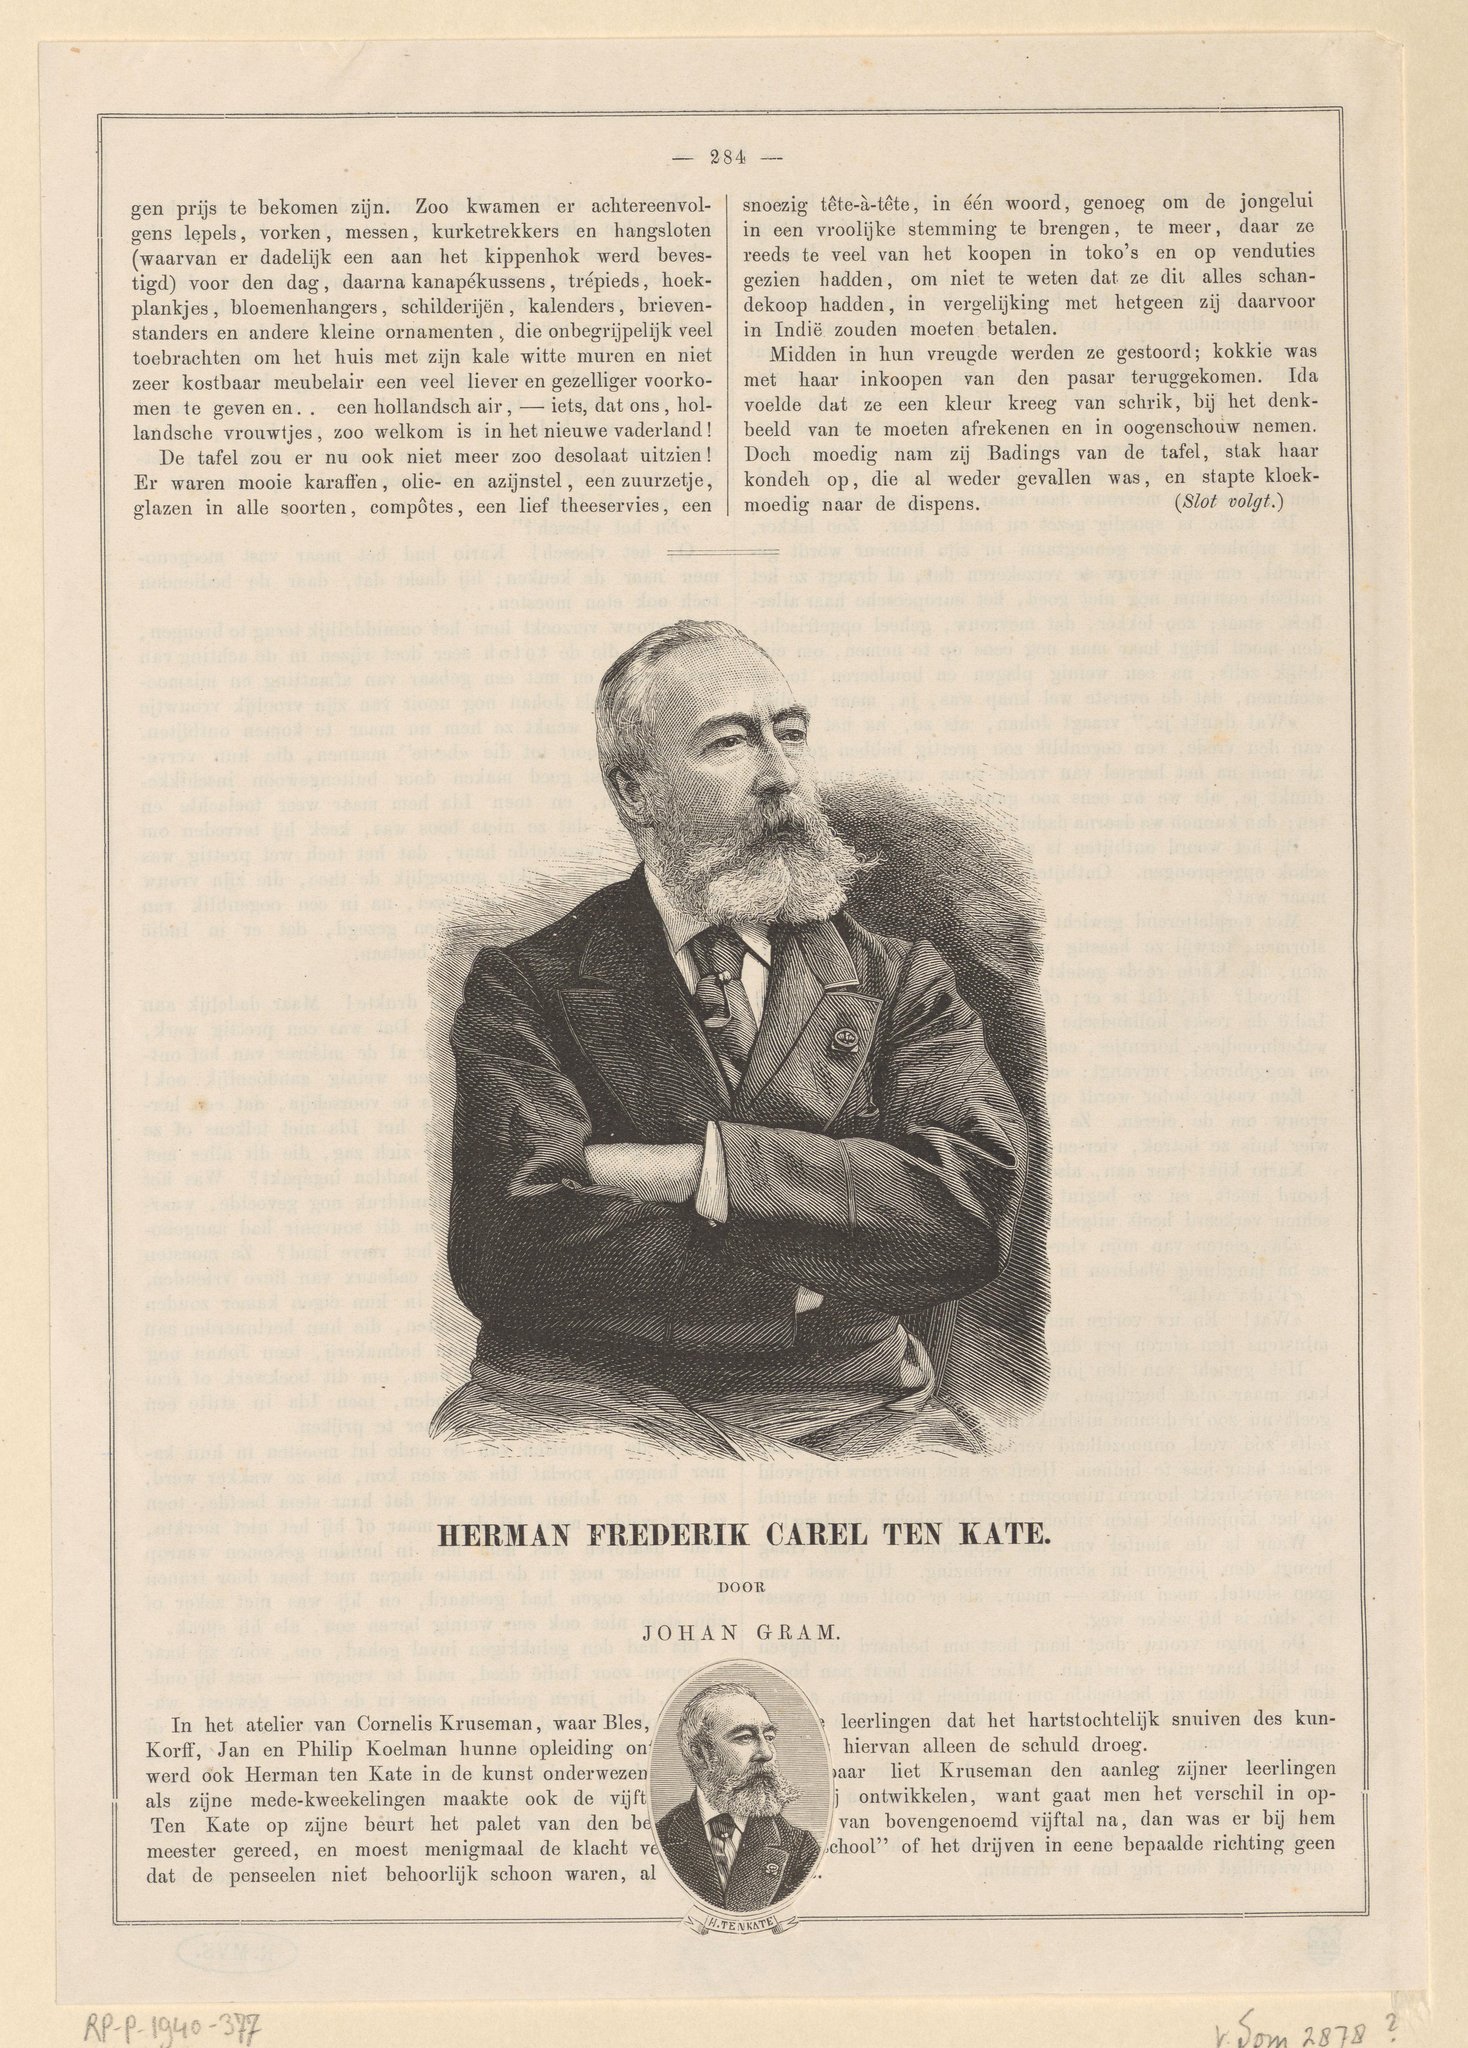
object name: print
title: Portret van Herman Frederik Carel ten Kate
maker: hermanus diedericus tjeenk willink (1843-1917)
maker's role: publisher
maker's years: 1843-1917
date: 1882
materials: paper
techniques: letterpress printing, engraving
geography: haarlem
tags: the hague, painter, print maker, draughtsman, herman frederik carel ten kate, historical persons, portrait, self-portrait of painter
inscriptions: collector's mark: Lugt 2760, collector's mark: Lugt 2228